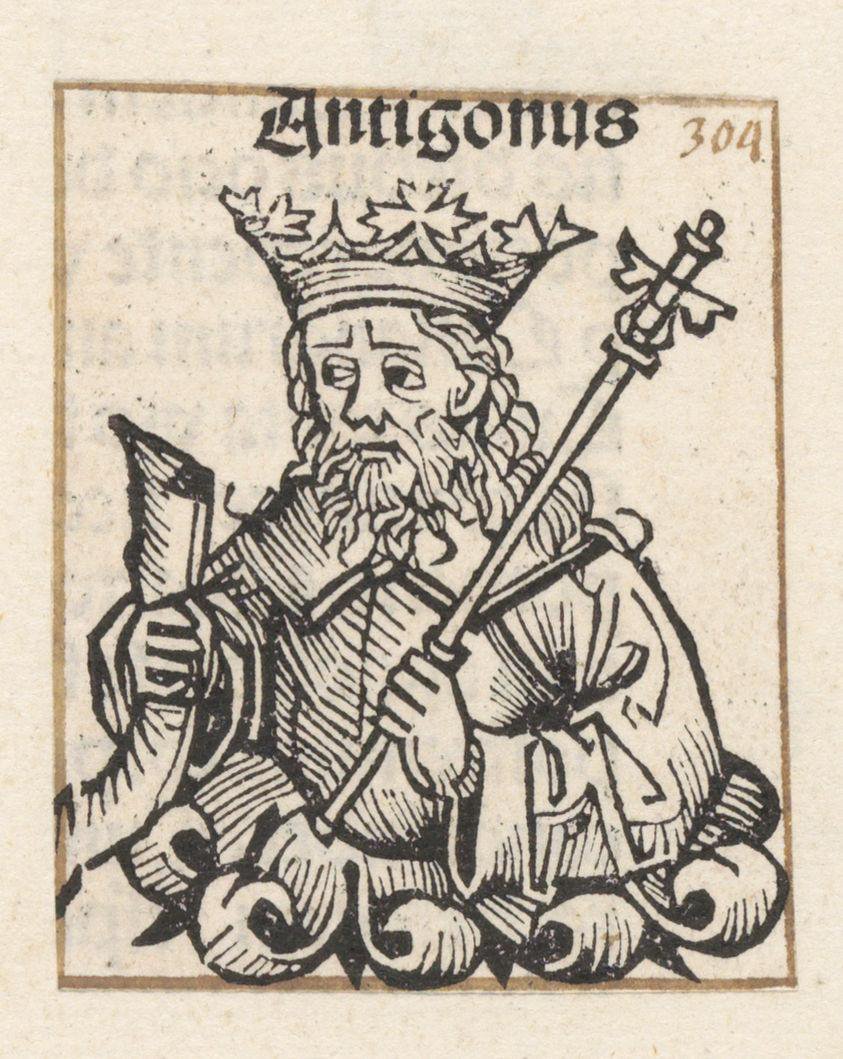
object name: album leaf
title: Koning Antigonos I Monophthalmos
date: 1493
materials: paper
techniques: letterpress printing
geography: nuremberg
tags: king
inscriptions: inscription: ‘304’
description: Een bloemkelk met een koning, naar links gekeerd. De man heeft een scepter in zijn handen. De voorstelling is onderdeel van de stamboom van Alexander de Grote in de Liber Chronicarum. De tekst identificeert hem als Antigonos I Monophthalmos. De prent maakt deel uit van een album.